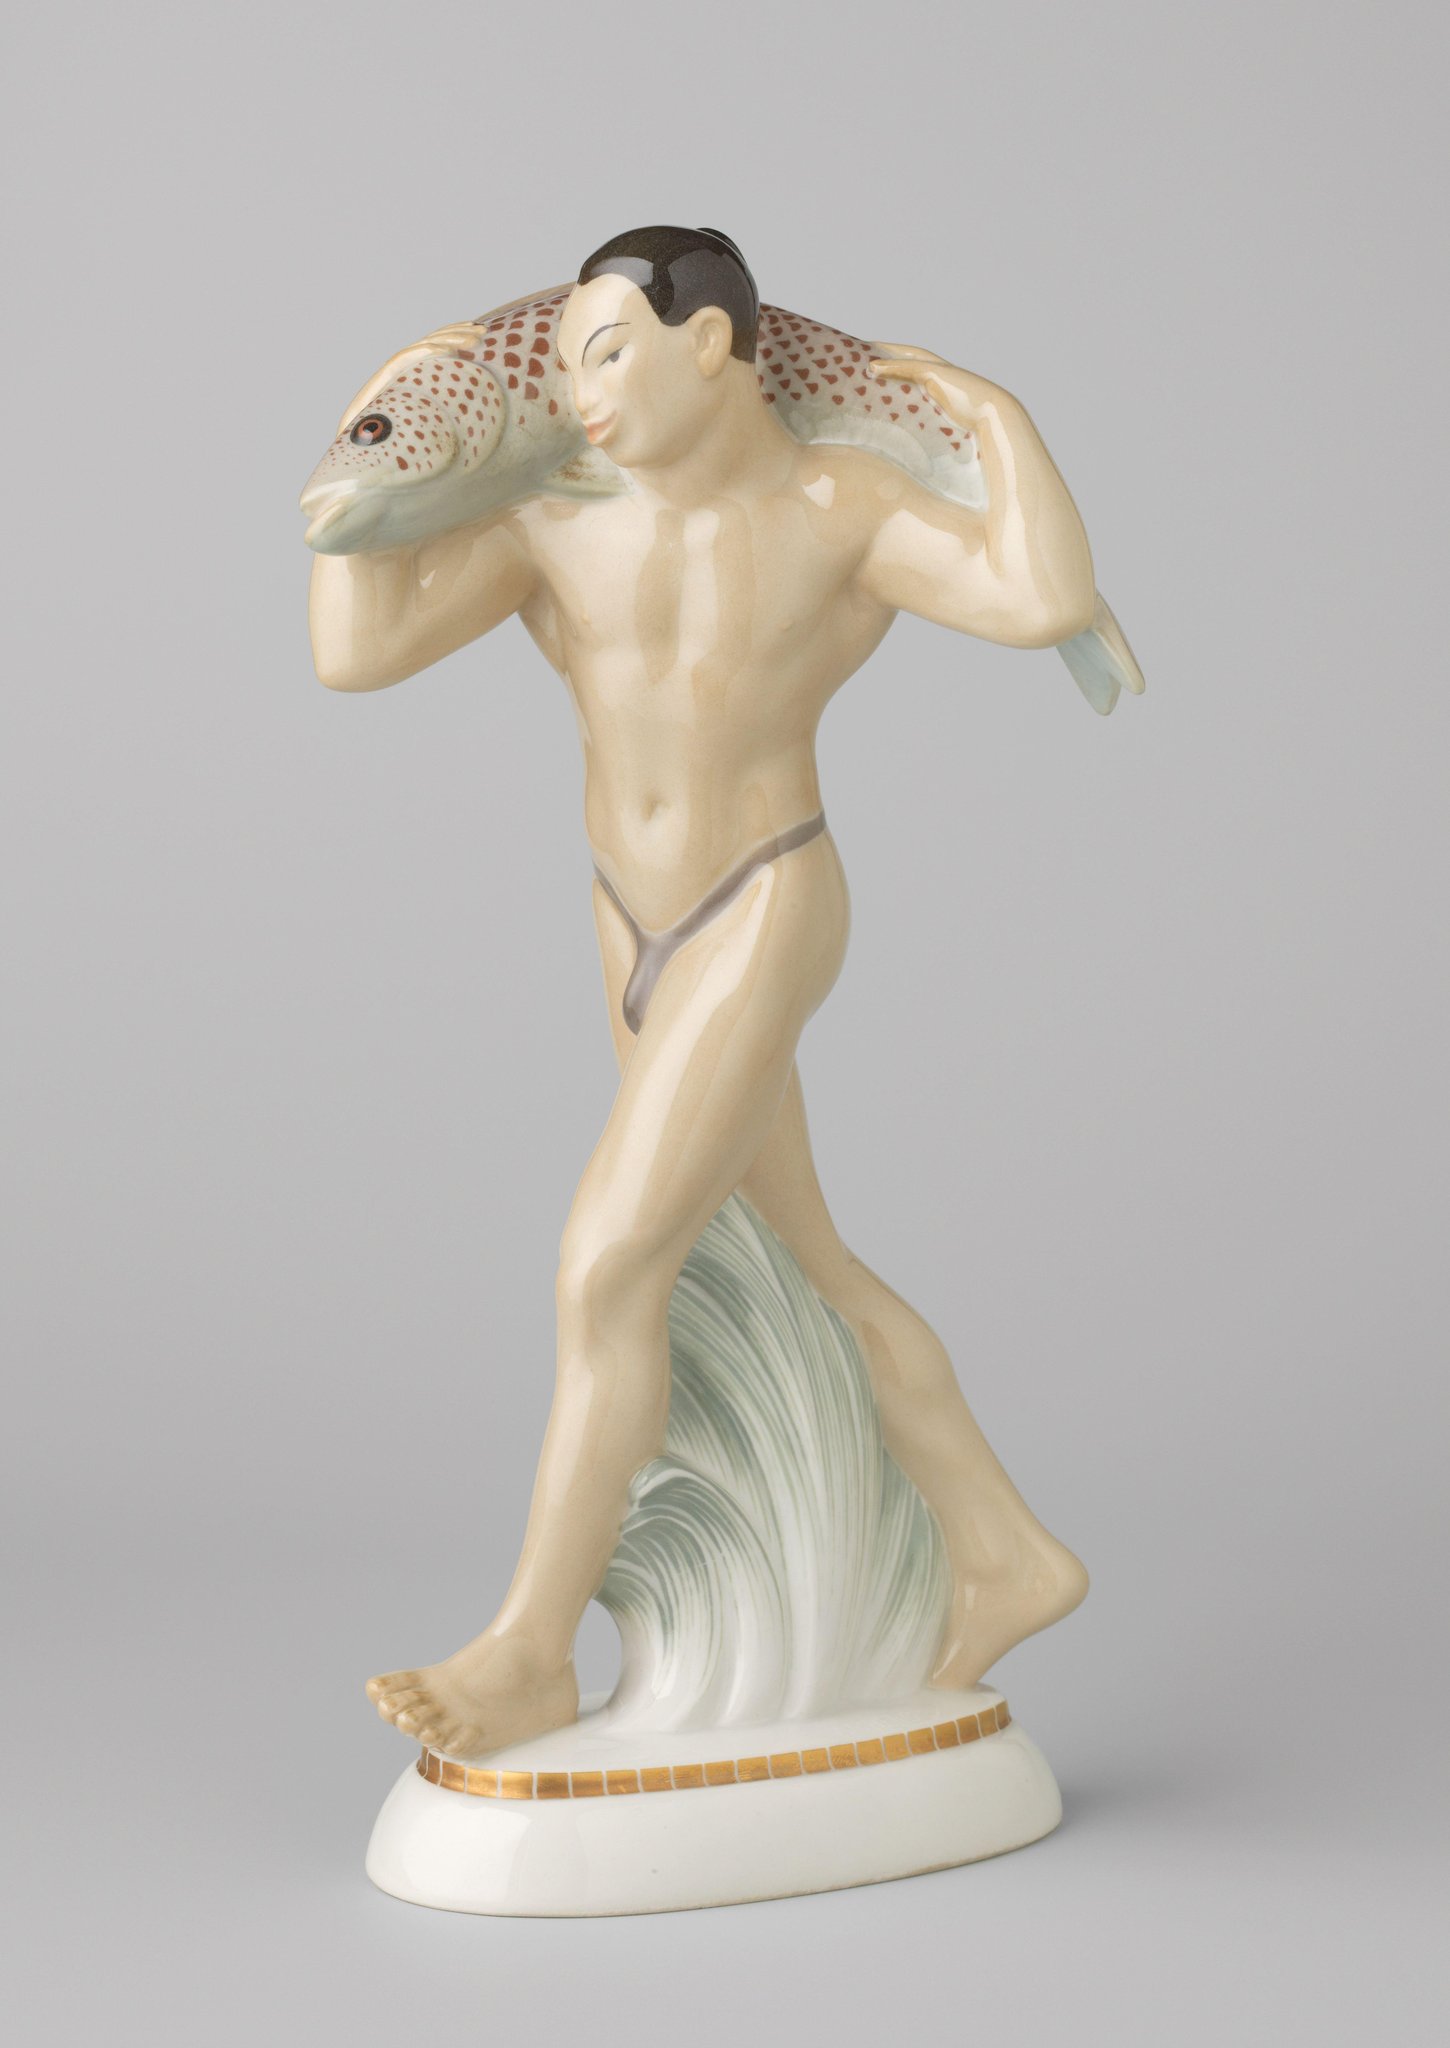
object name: figure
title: Figure in the shape of a Japanese man with a fish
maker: adolf amberg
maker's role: designer, sculptor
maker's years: 1874-1913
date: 1911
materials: glaze, paint, porcelain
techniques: firing, forming, vitrification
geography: berlin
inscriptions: mark: ‘scepter/ 140/645/ rijksappel met K.P.M in rood en blauw/ I.O (1911)/ 9615 B’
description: Japanese man with fish. Porcelain. Berlin, Königliche Porzellan Manufaktur, 1911, designed by Adolf Amberg 1905.